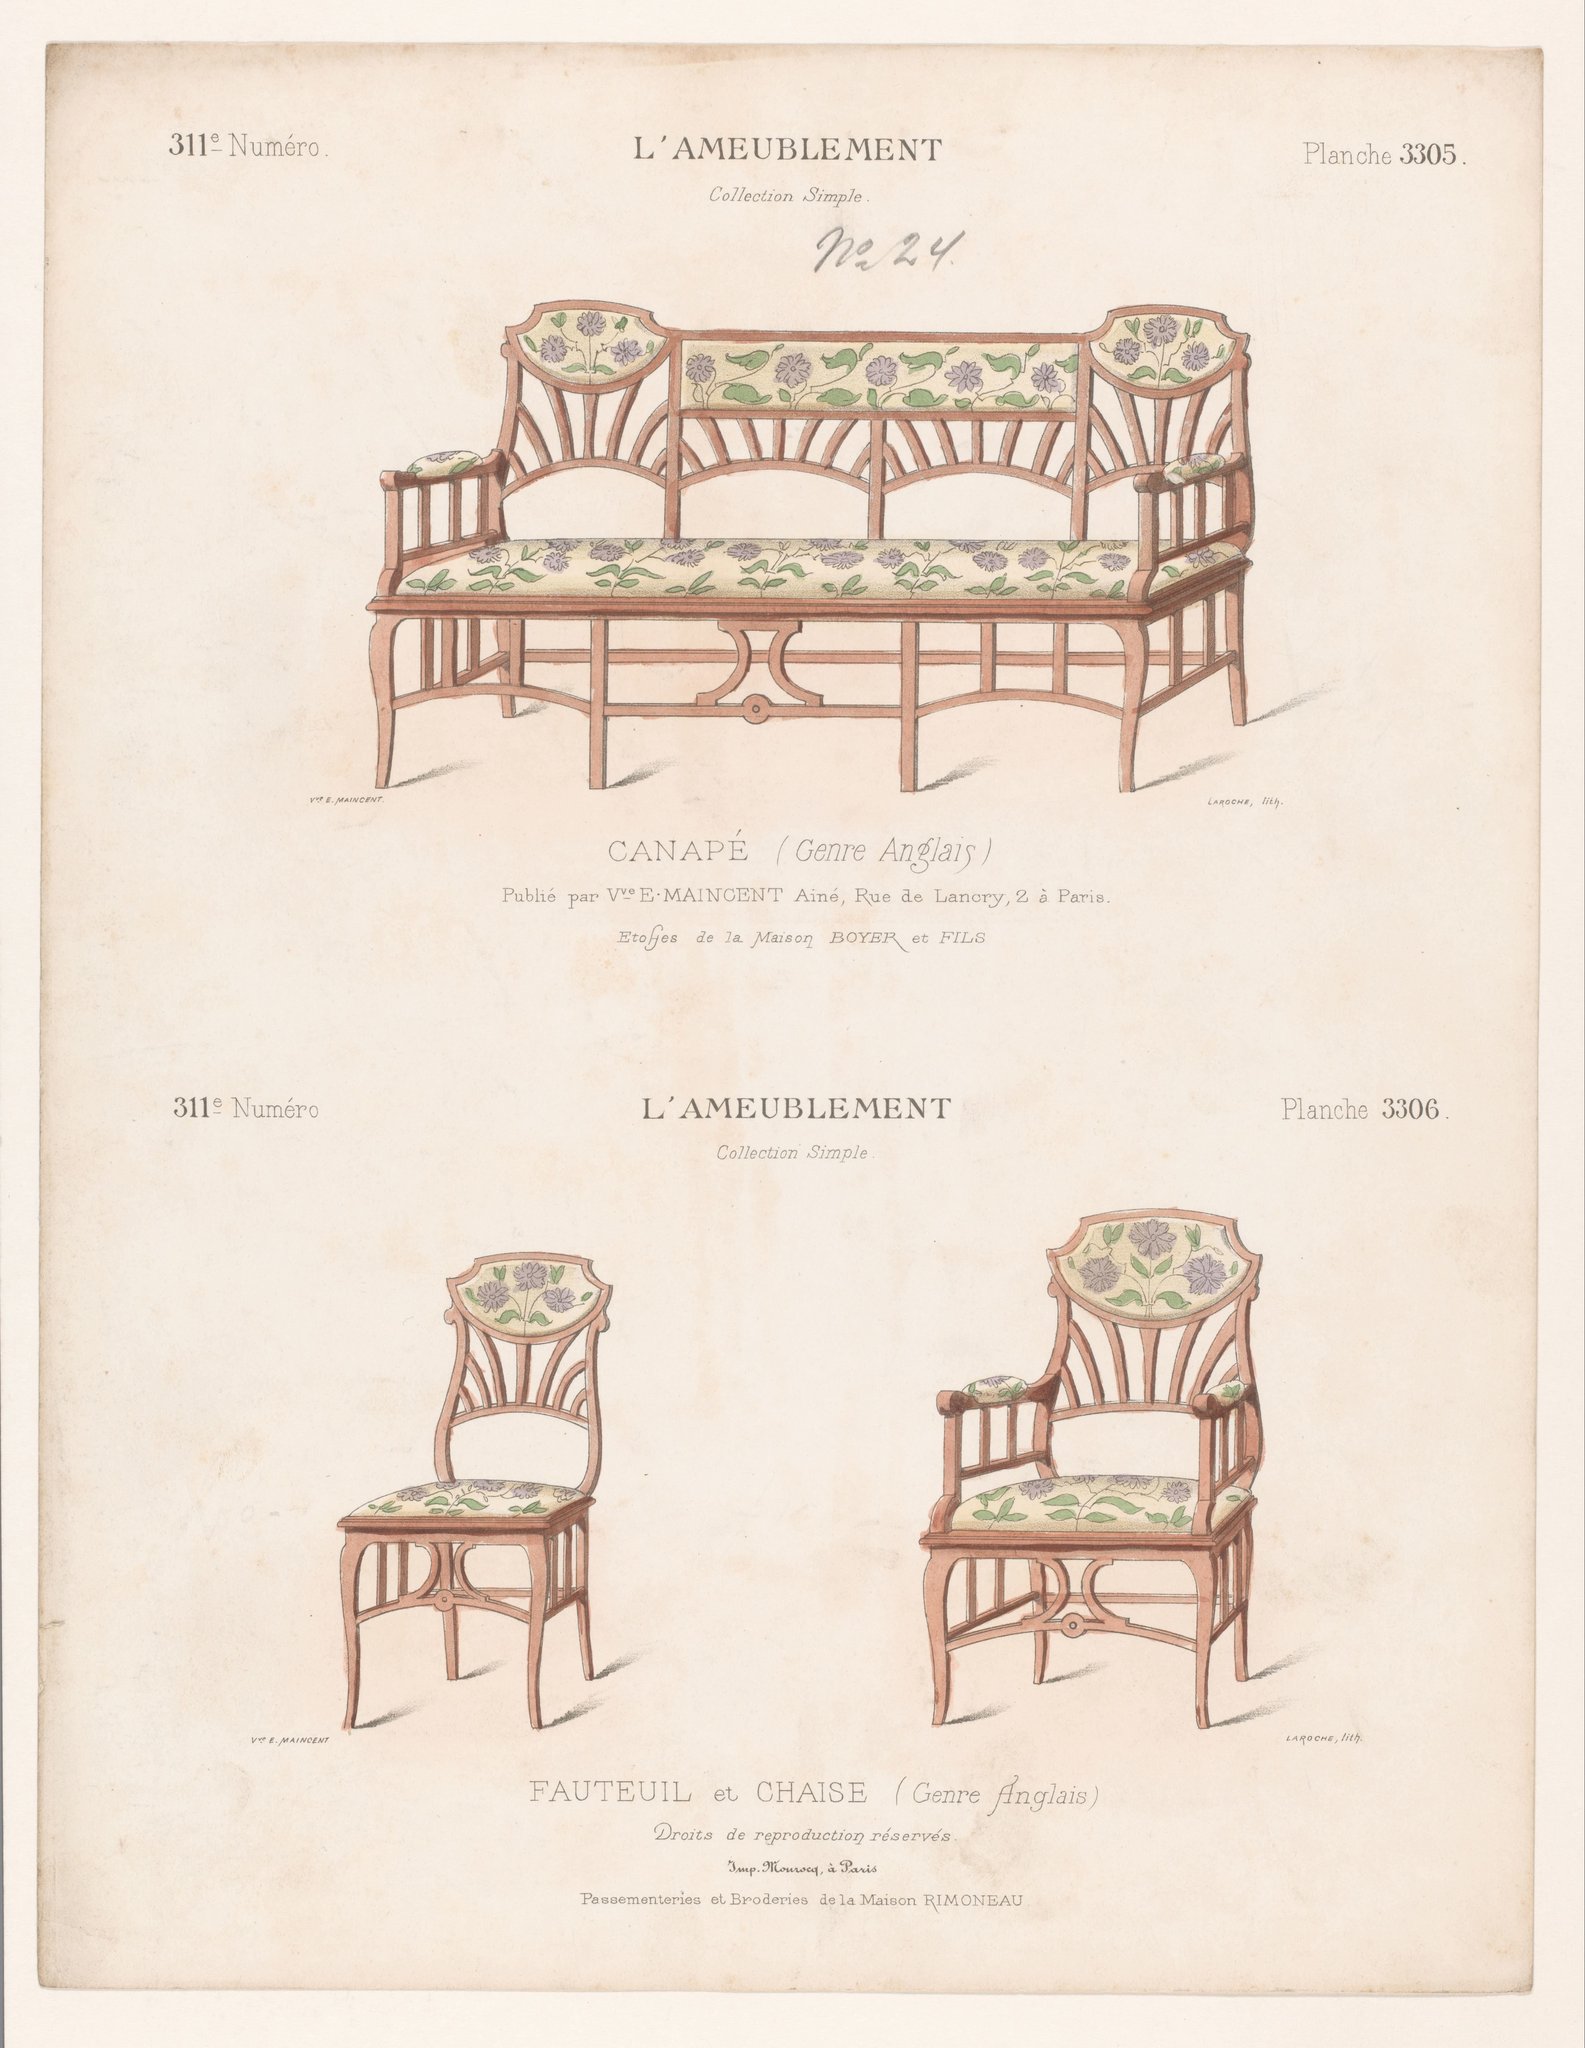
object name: print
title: Canapé (Genre Anglais) / Fauteuil et chaise (Genre Anglais)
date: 1895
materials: paper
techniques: hand coloring, lithograph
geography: paris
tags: seating furniture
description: Een canapé, fauteuil en een stoel. Prent uit 311e nummer (livraison).